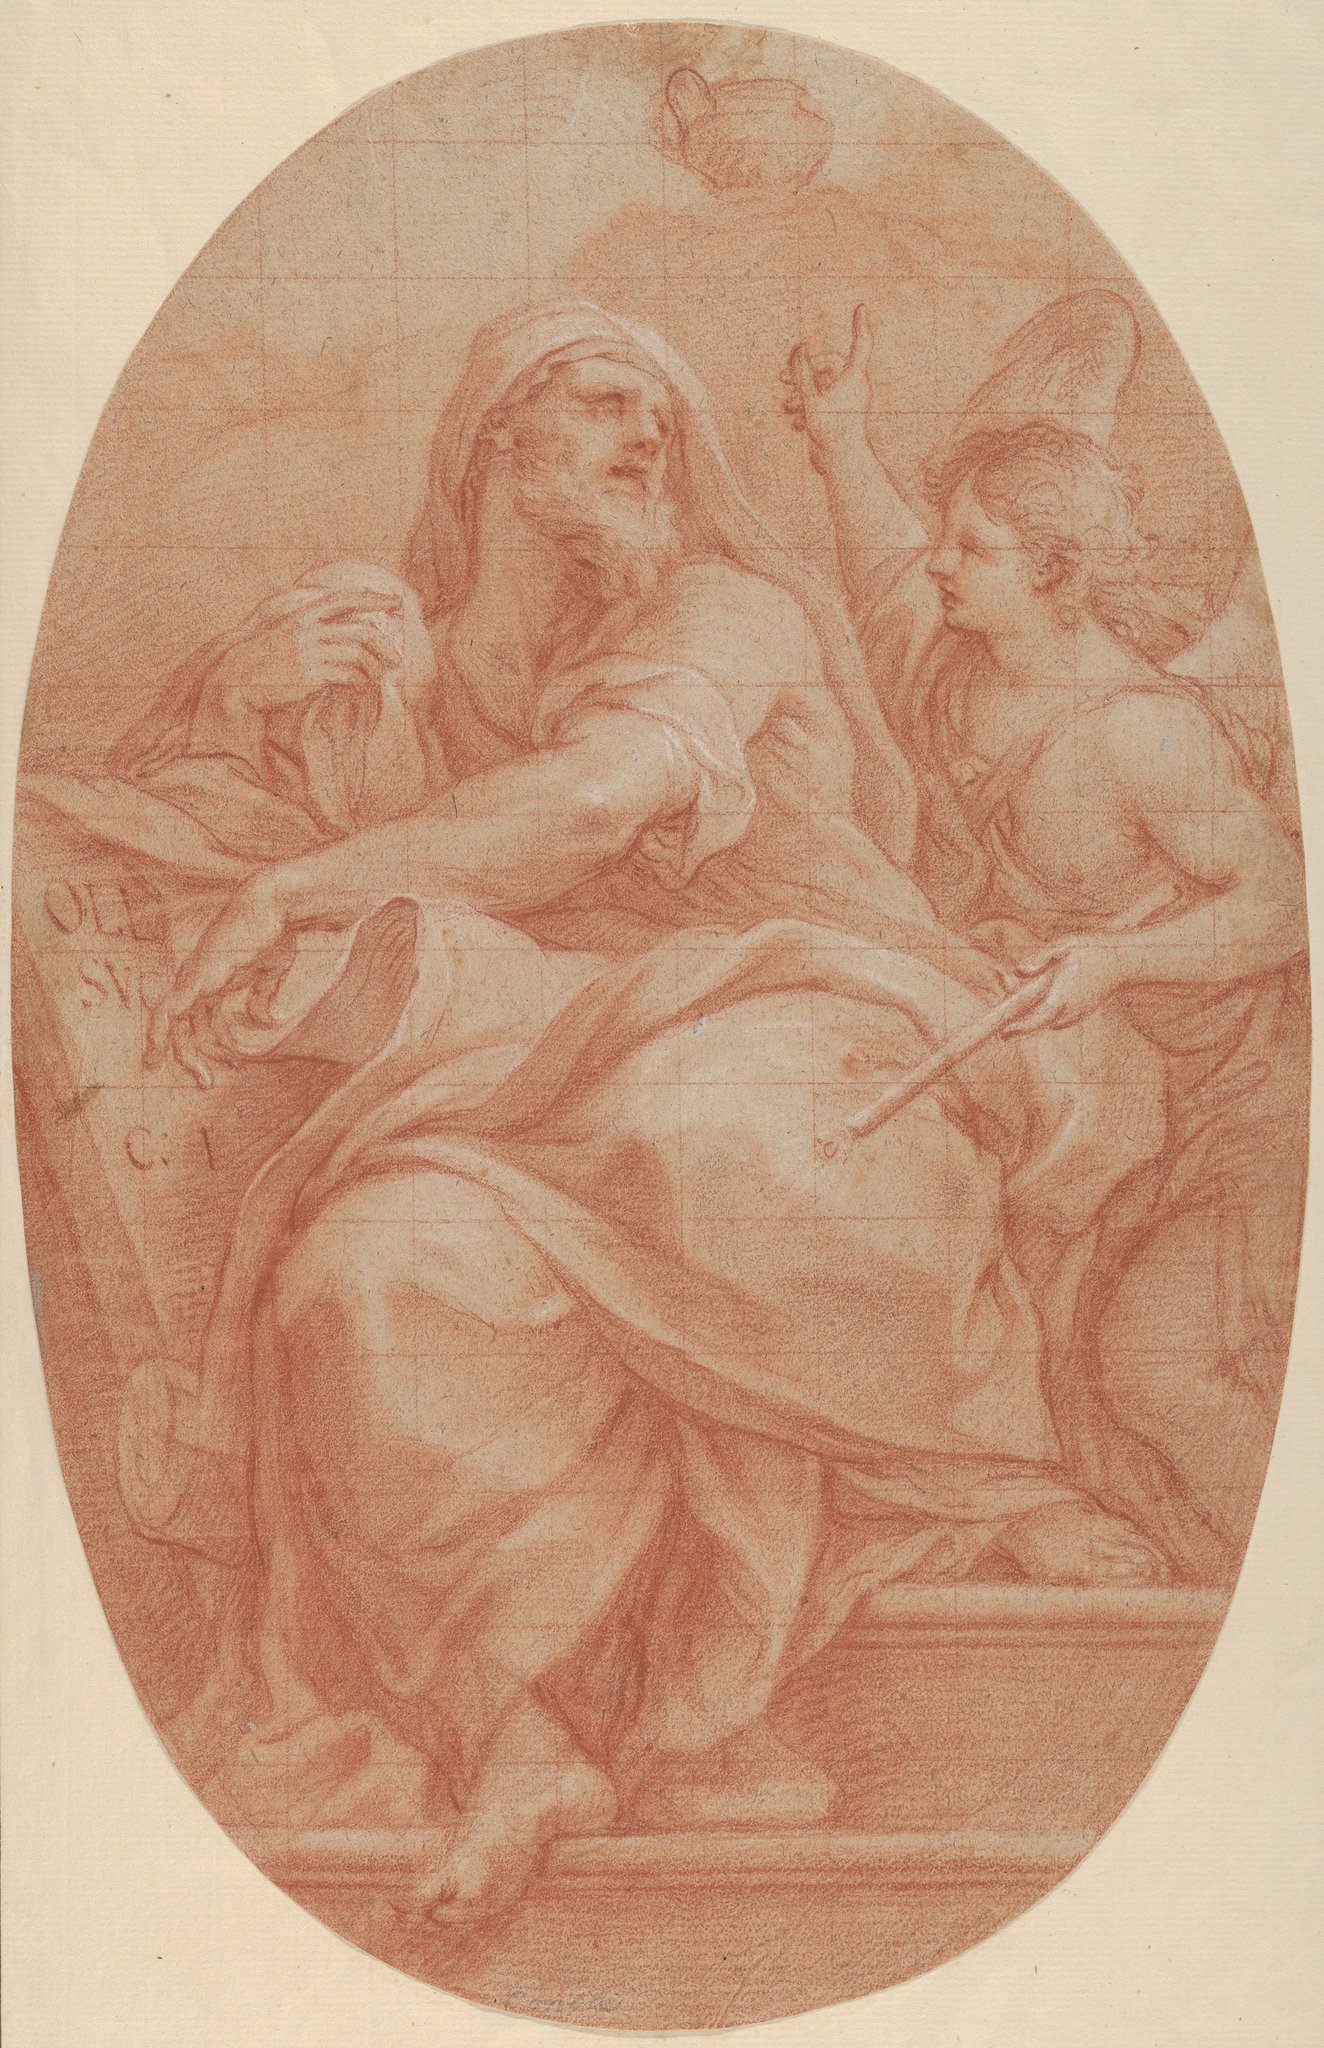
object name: drawing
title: The Prophet Jeremiah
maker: sebastiano conca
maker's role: artist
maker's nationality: italian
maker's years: 1676-1764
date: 1718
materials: chalk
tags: men,saints